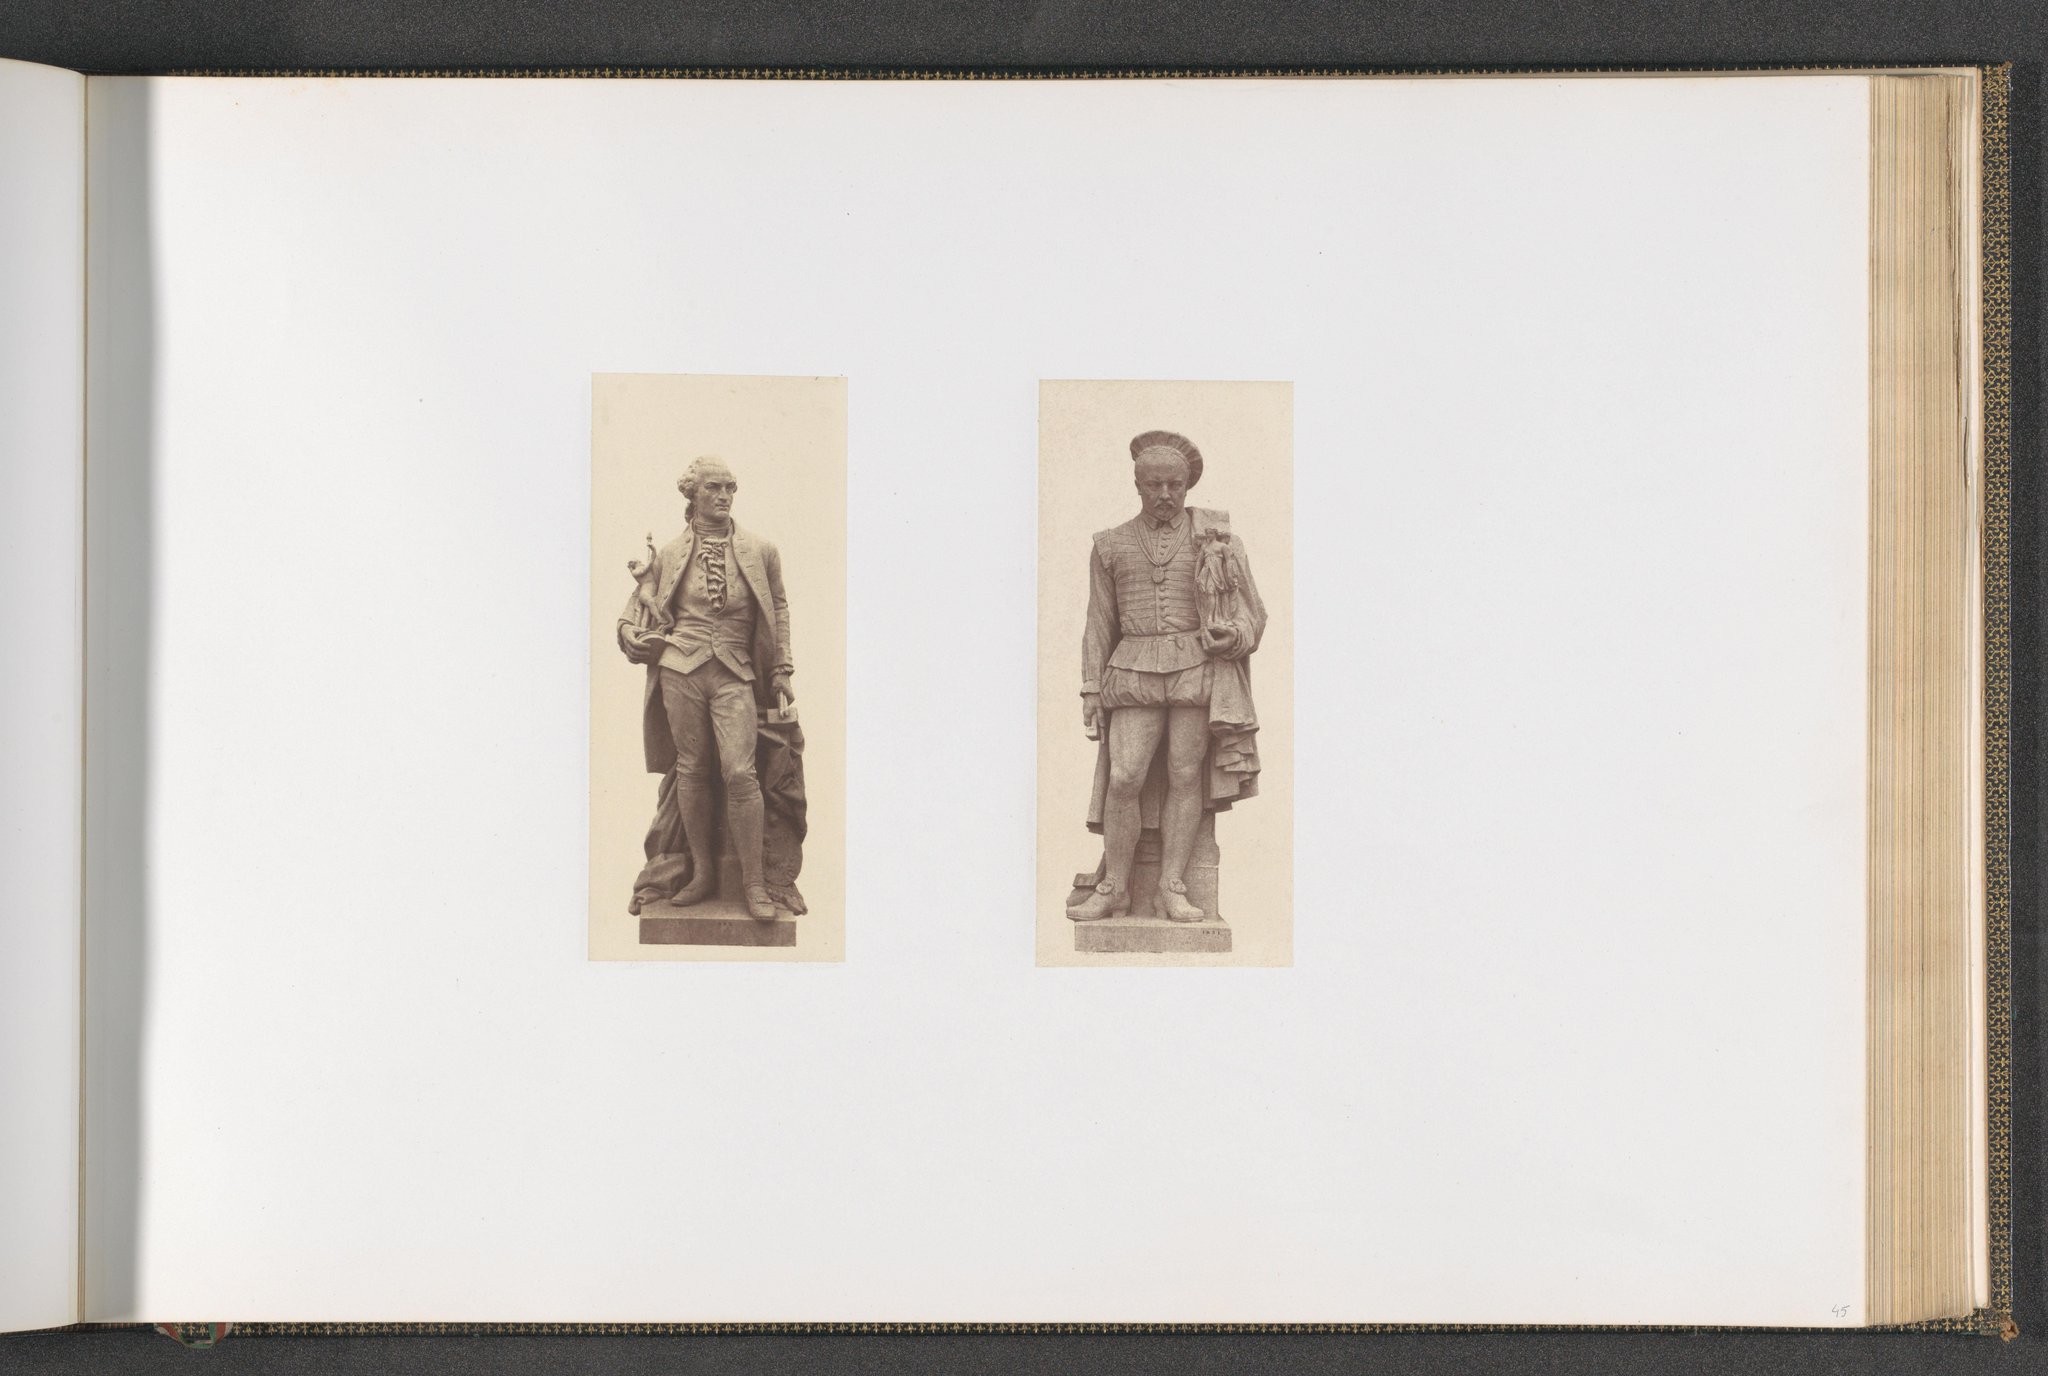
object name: photograph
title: Gipsmodellen voor beeldhouwwerken op het Palais du Louvre: links "Clodion" door Vital Dubray en rechts "Pilon" door Louis Desprez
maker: édouard denis baldus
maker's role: fotograaf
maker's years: 1813-1889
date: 1855-1857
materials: paper, photographic support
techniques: salted paper print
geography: paris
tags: piece of sculpture, reproduction of a piece of sculpture, permanent exhibition, museum, paris, tuileries palace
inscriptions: number: ‘992 en 1031’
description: Onderdeel van Réunion des Tuileries au Louvre 1852-1857, album 2.